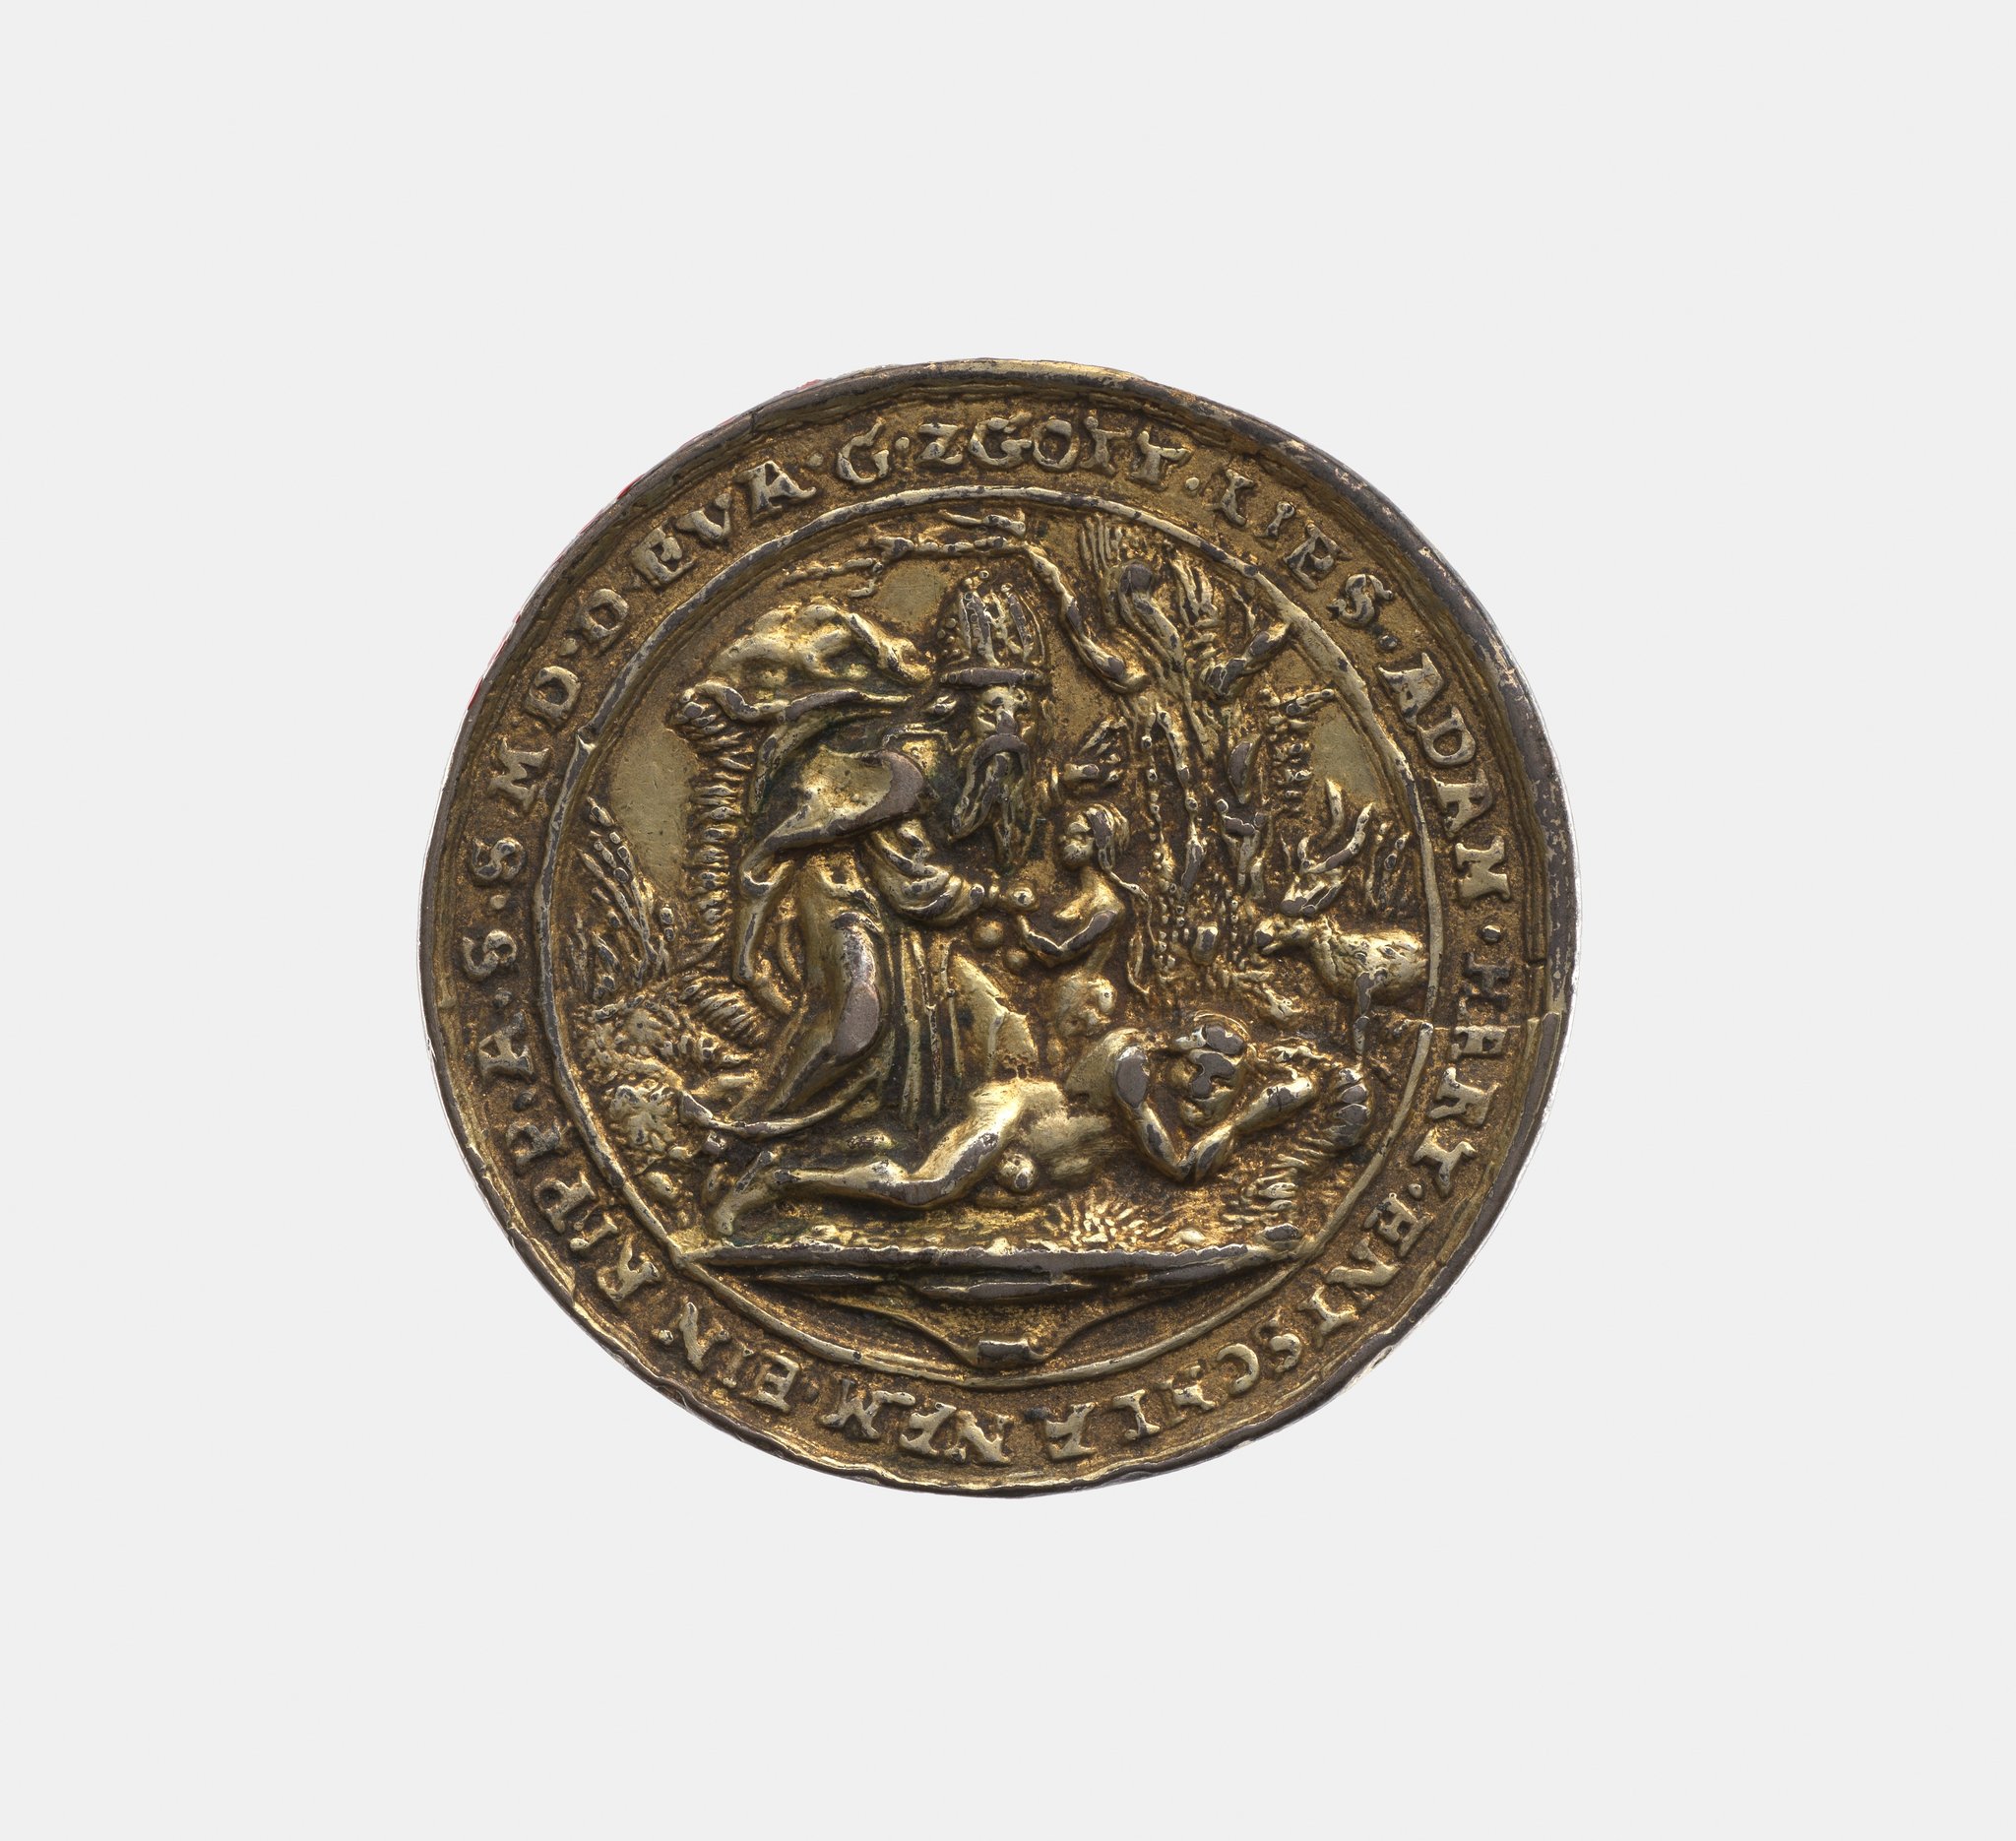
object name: medal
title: Creation of Eve | Marriage at Cana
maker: nickel milicz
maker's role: artist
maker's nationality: czech, jáchymov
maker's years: 1544-1570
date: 1552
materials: silver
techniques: gilding